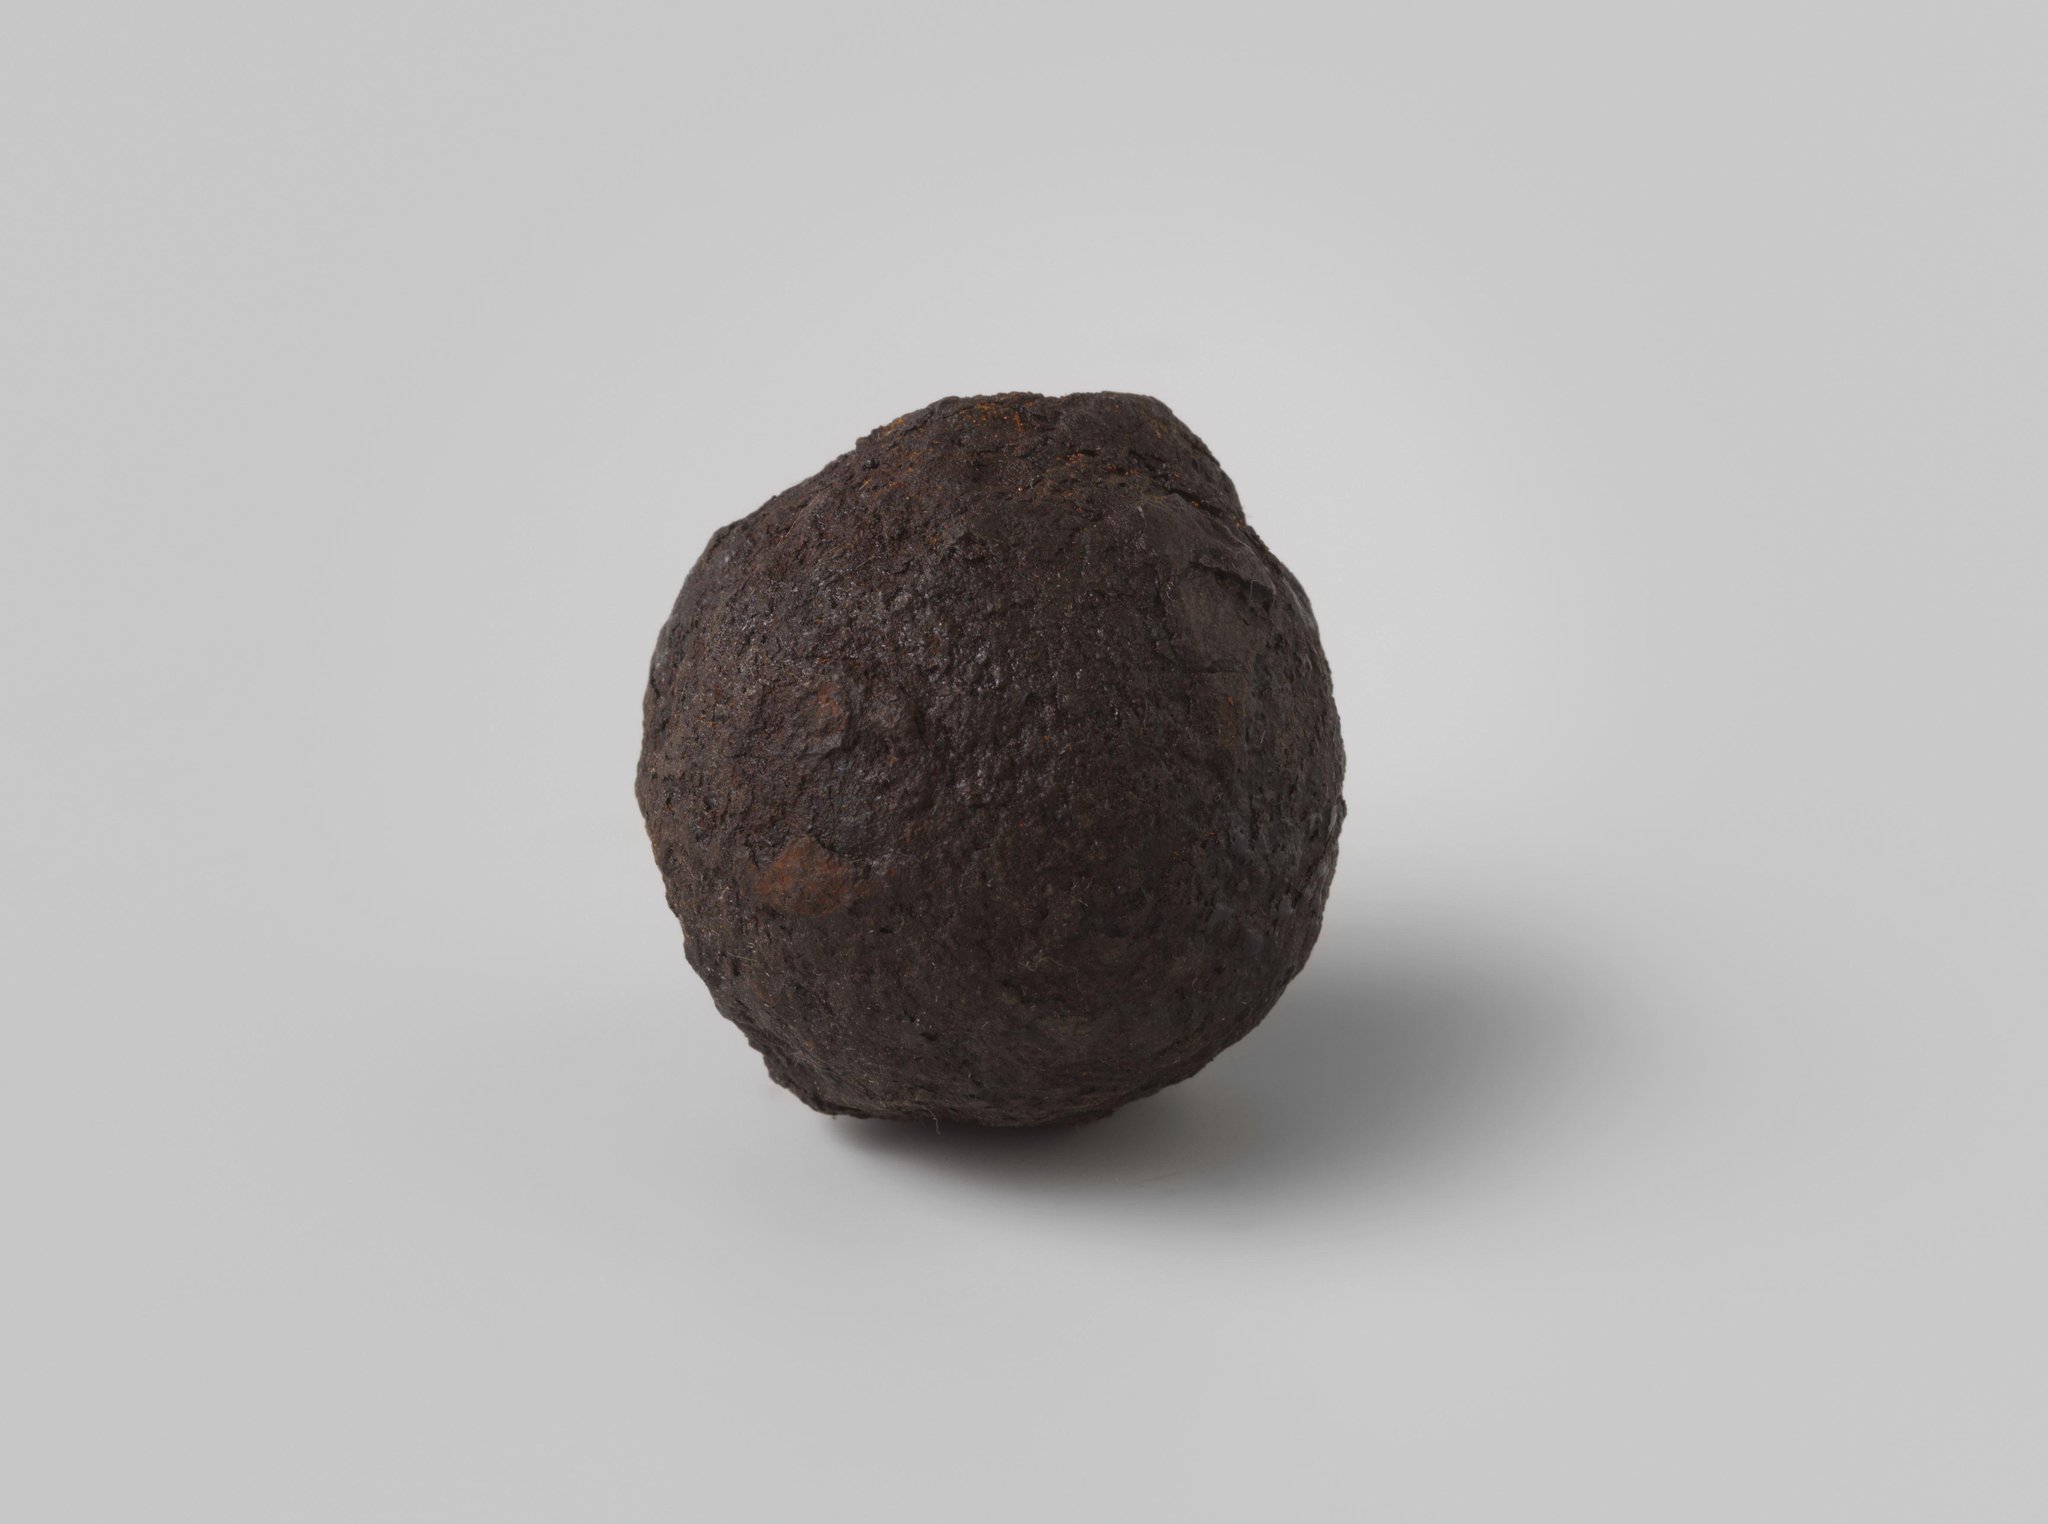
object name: bullet ammunition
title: Kogel uit het wrak van de Oost-Indiëvaarder Hollandia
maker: Anonymous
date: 1700-1743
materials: iron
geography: netherlands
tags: verenigde oostindische compagnie, hollandia (schip), annet